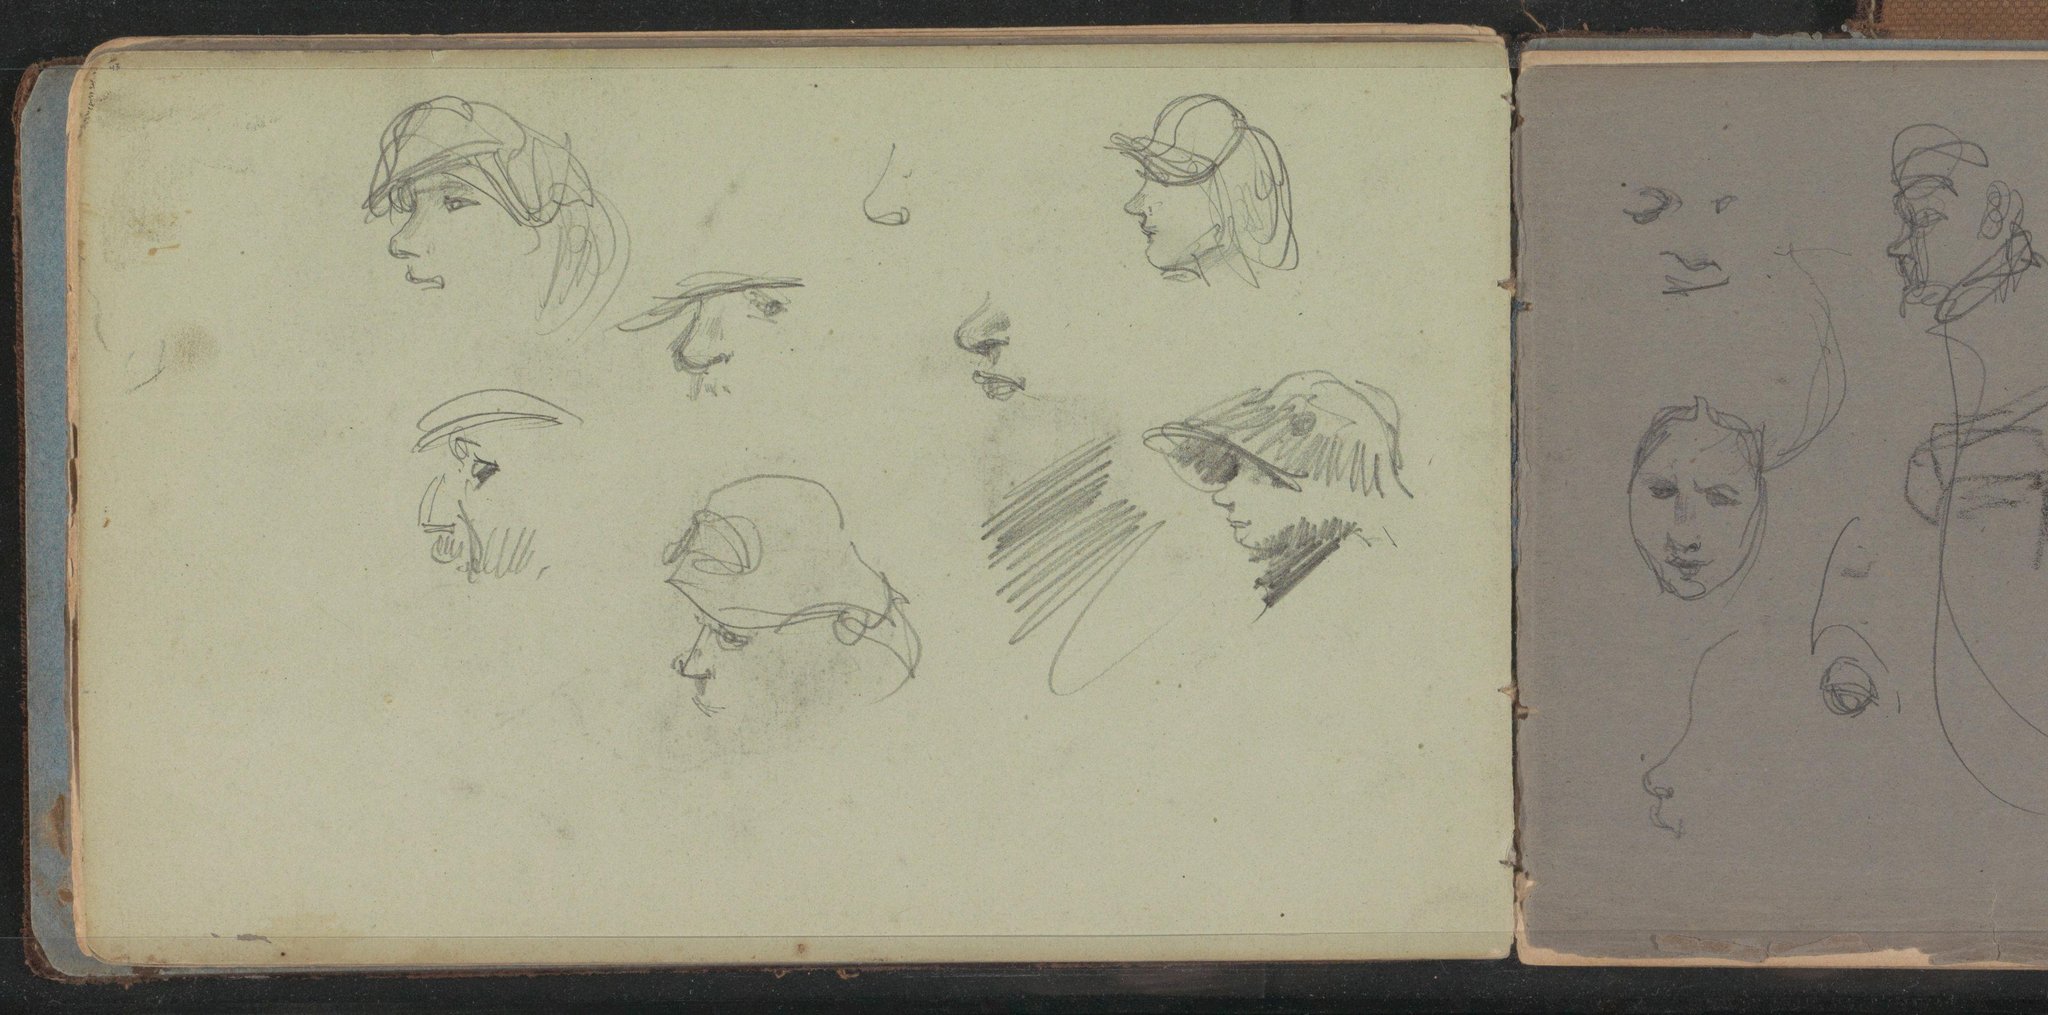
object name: sketchbook leaf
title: Studieblad met hoofden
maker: george hendrik breitner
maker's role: draughtsman, painter, print maker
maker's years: 1857-1923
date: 1880-1882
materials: paper, pencil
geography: scheveningen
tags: head-gear: hat (+ women's clothes), head (human) - aa - female human figure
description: Voornamelijk vrouwenhoofden met hoeden. Pagina 43 uit een schetsboek met 37 bladen.